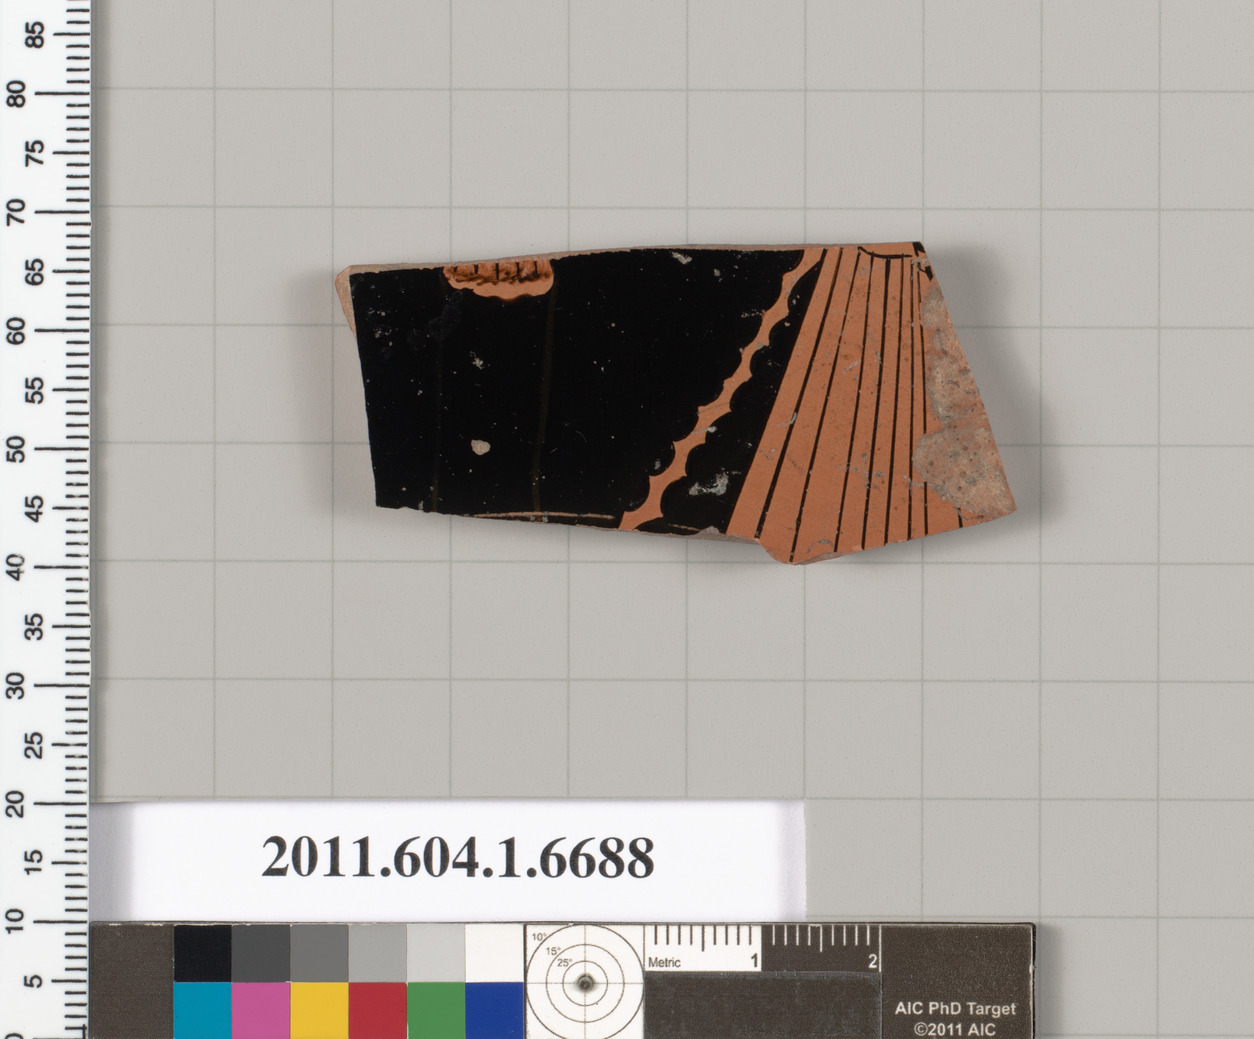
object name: kylix fragment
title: Terracotta fragment of a kylix (drinking cup)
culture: greek, attic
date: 490-470 BCE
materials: terracotta